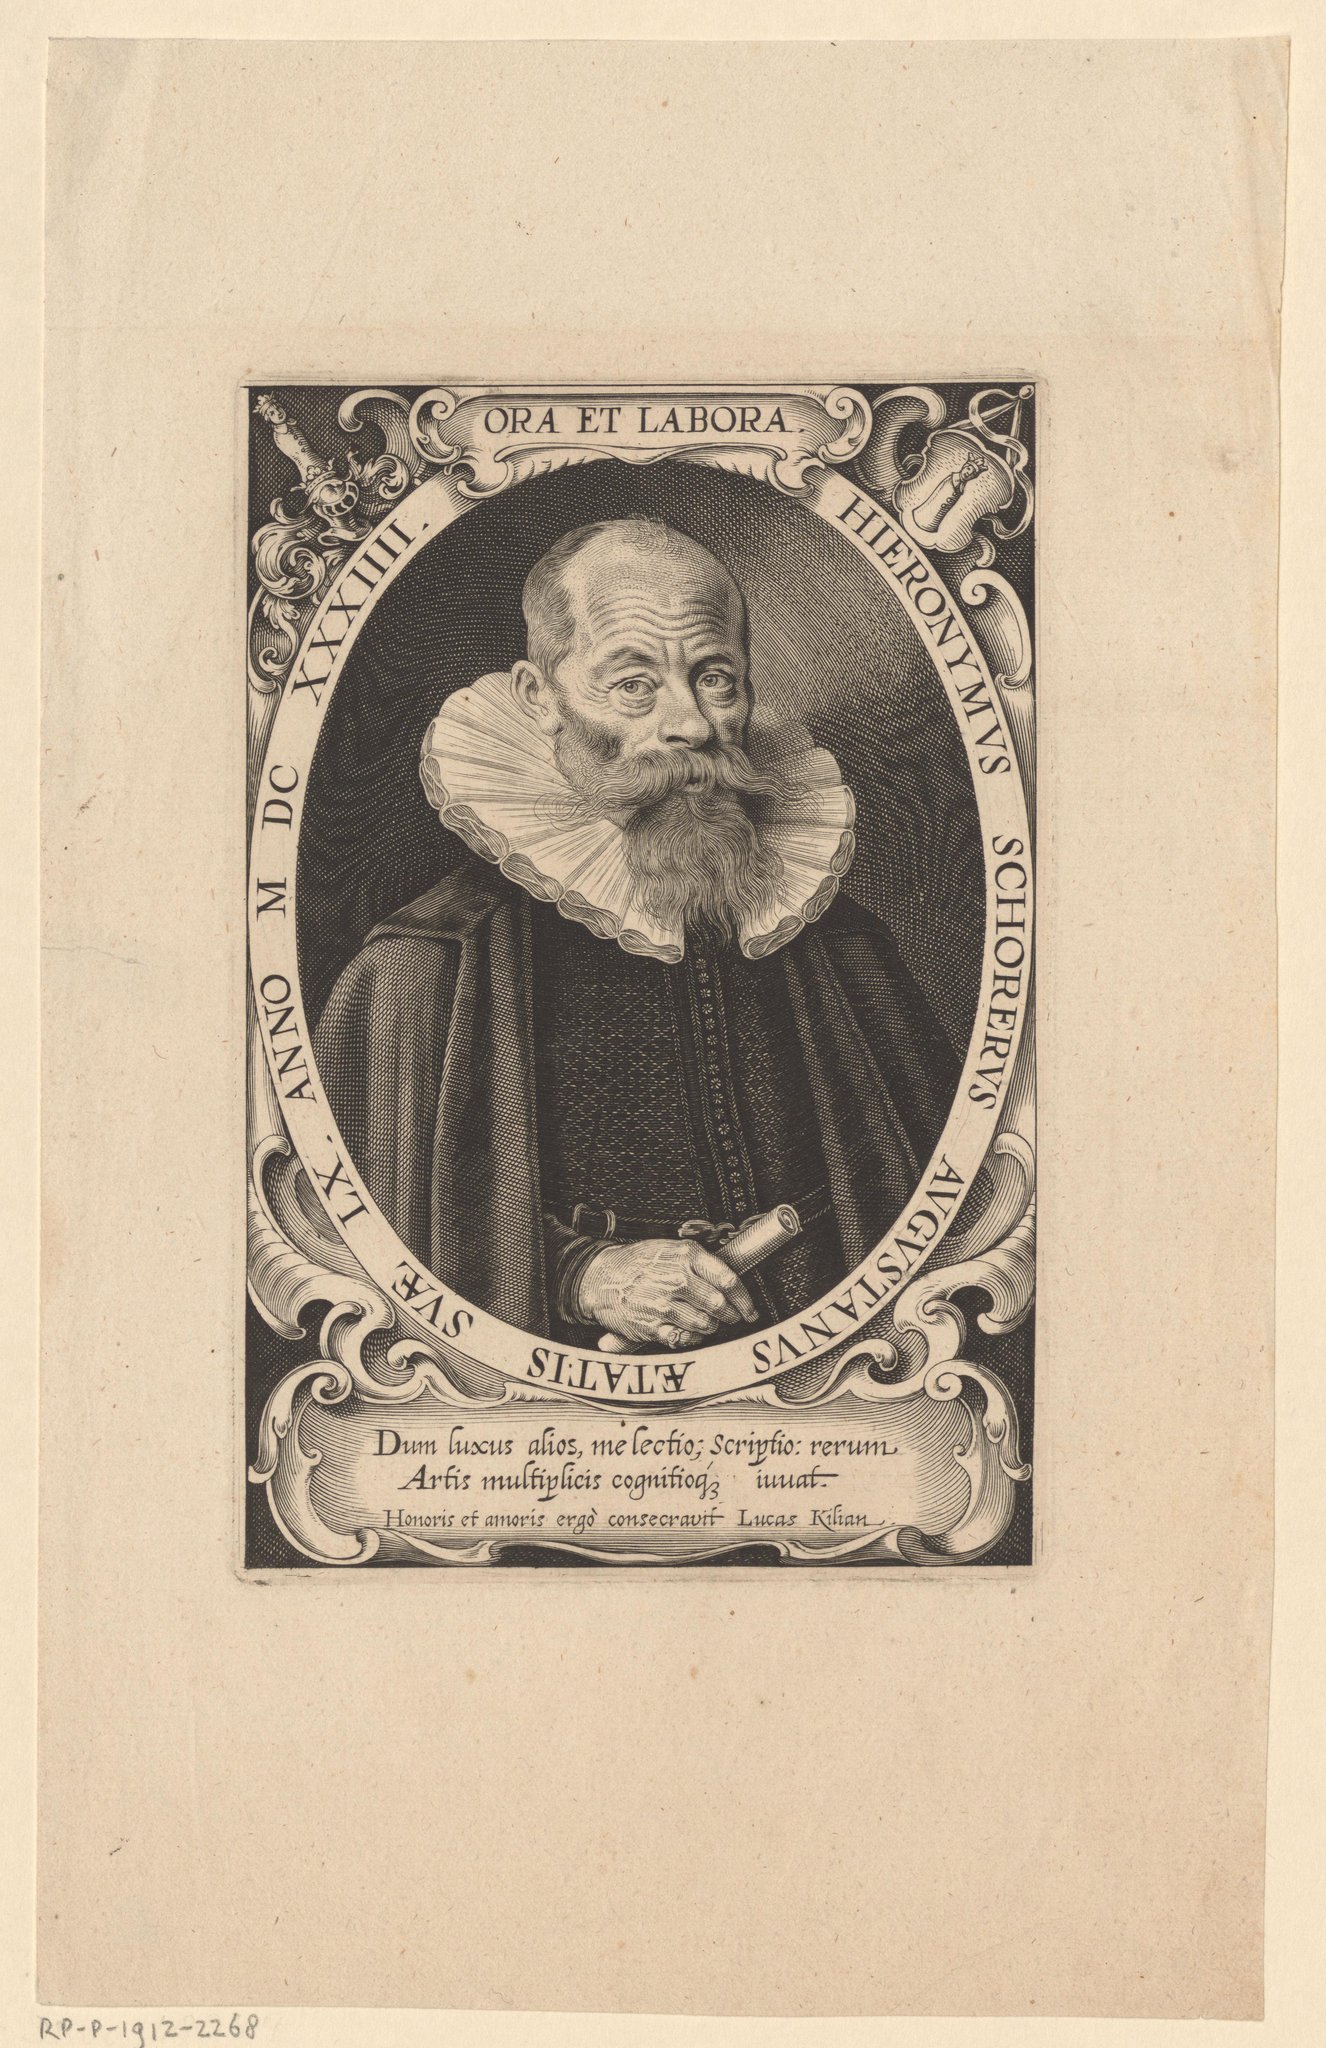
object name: print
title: Portret van Hieronymus Schorer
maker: lucas kilian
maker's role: draughtsman, print maker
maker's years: 1579-1637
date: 1634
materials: paper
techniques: engraving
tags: hieronymus schorer, historical persons, person stimulating the arts; art lover, connoisseur, maecenas, patron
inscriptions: collector's mark: Lugt 2228